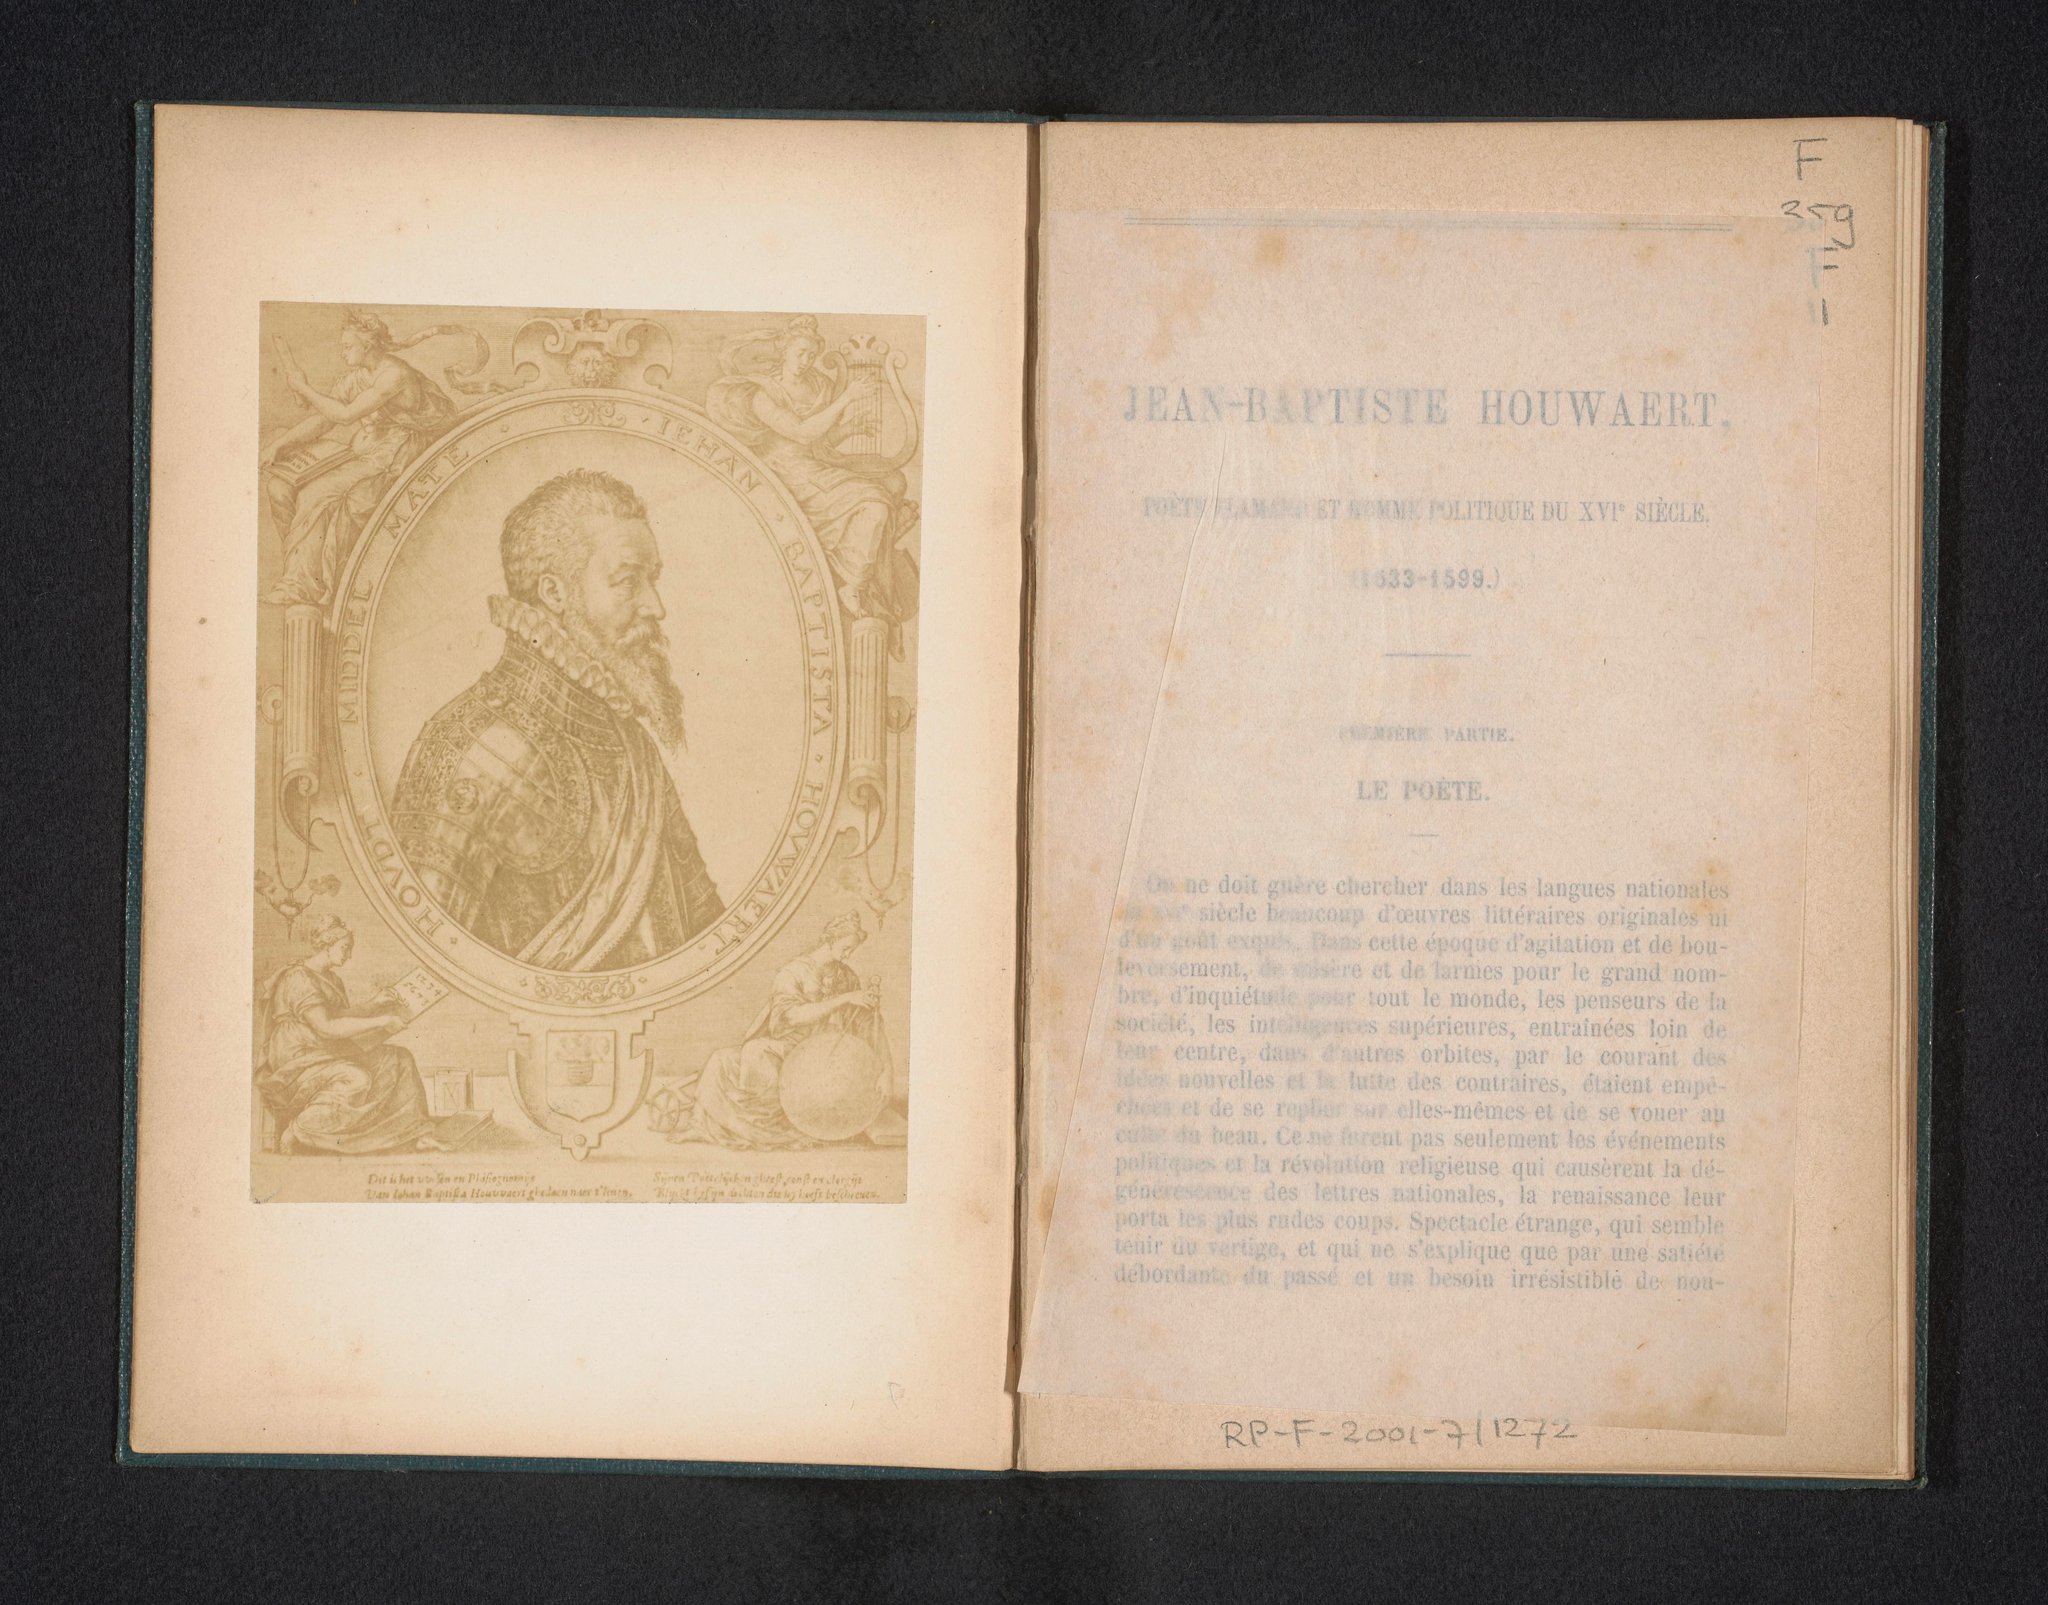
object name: page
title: Fotoreproductie van een prent van een portret van Jean-Baptiste Houwaert door Johannes Wierix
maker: Anonymous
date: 1857-1862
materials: photographic support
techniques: albumen print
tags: historical persons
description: Foto tegenover titelpagina, achter semi-transparante omslag.